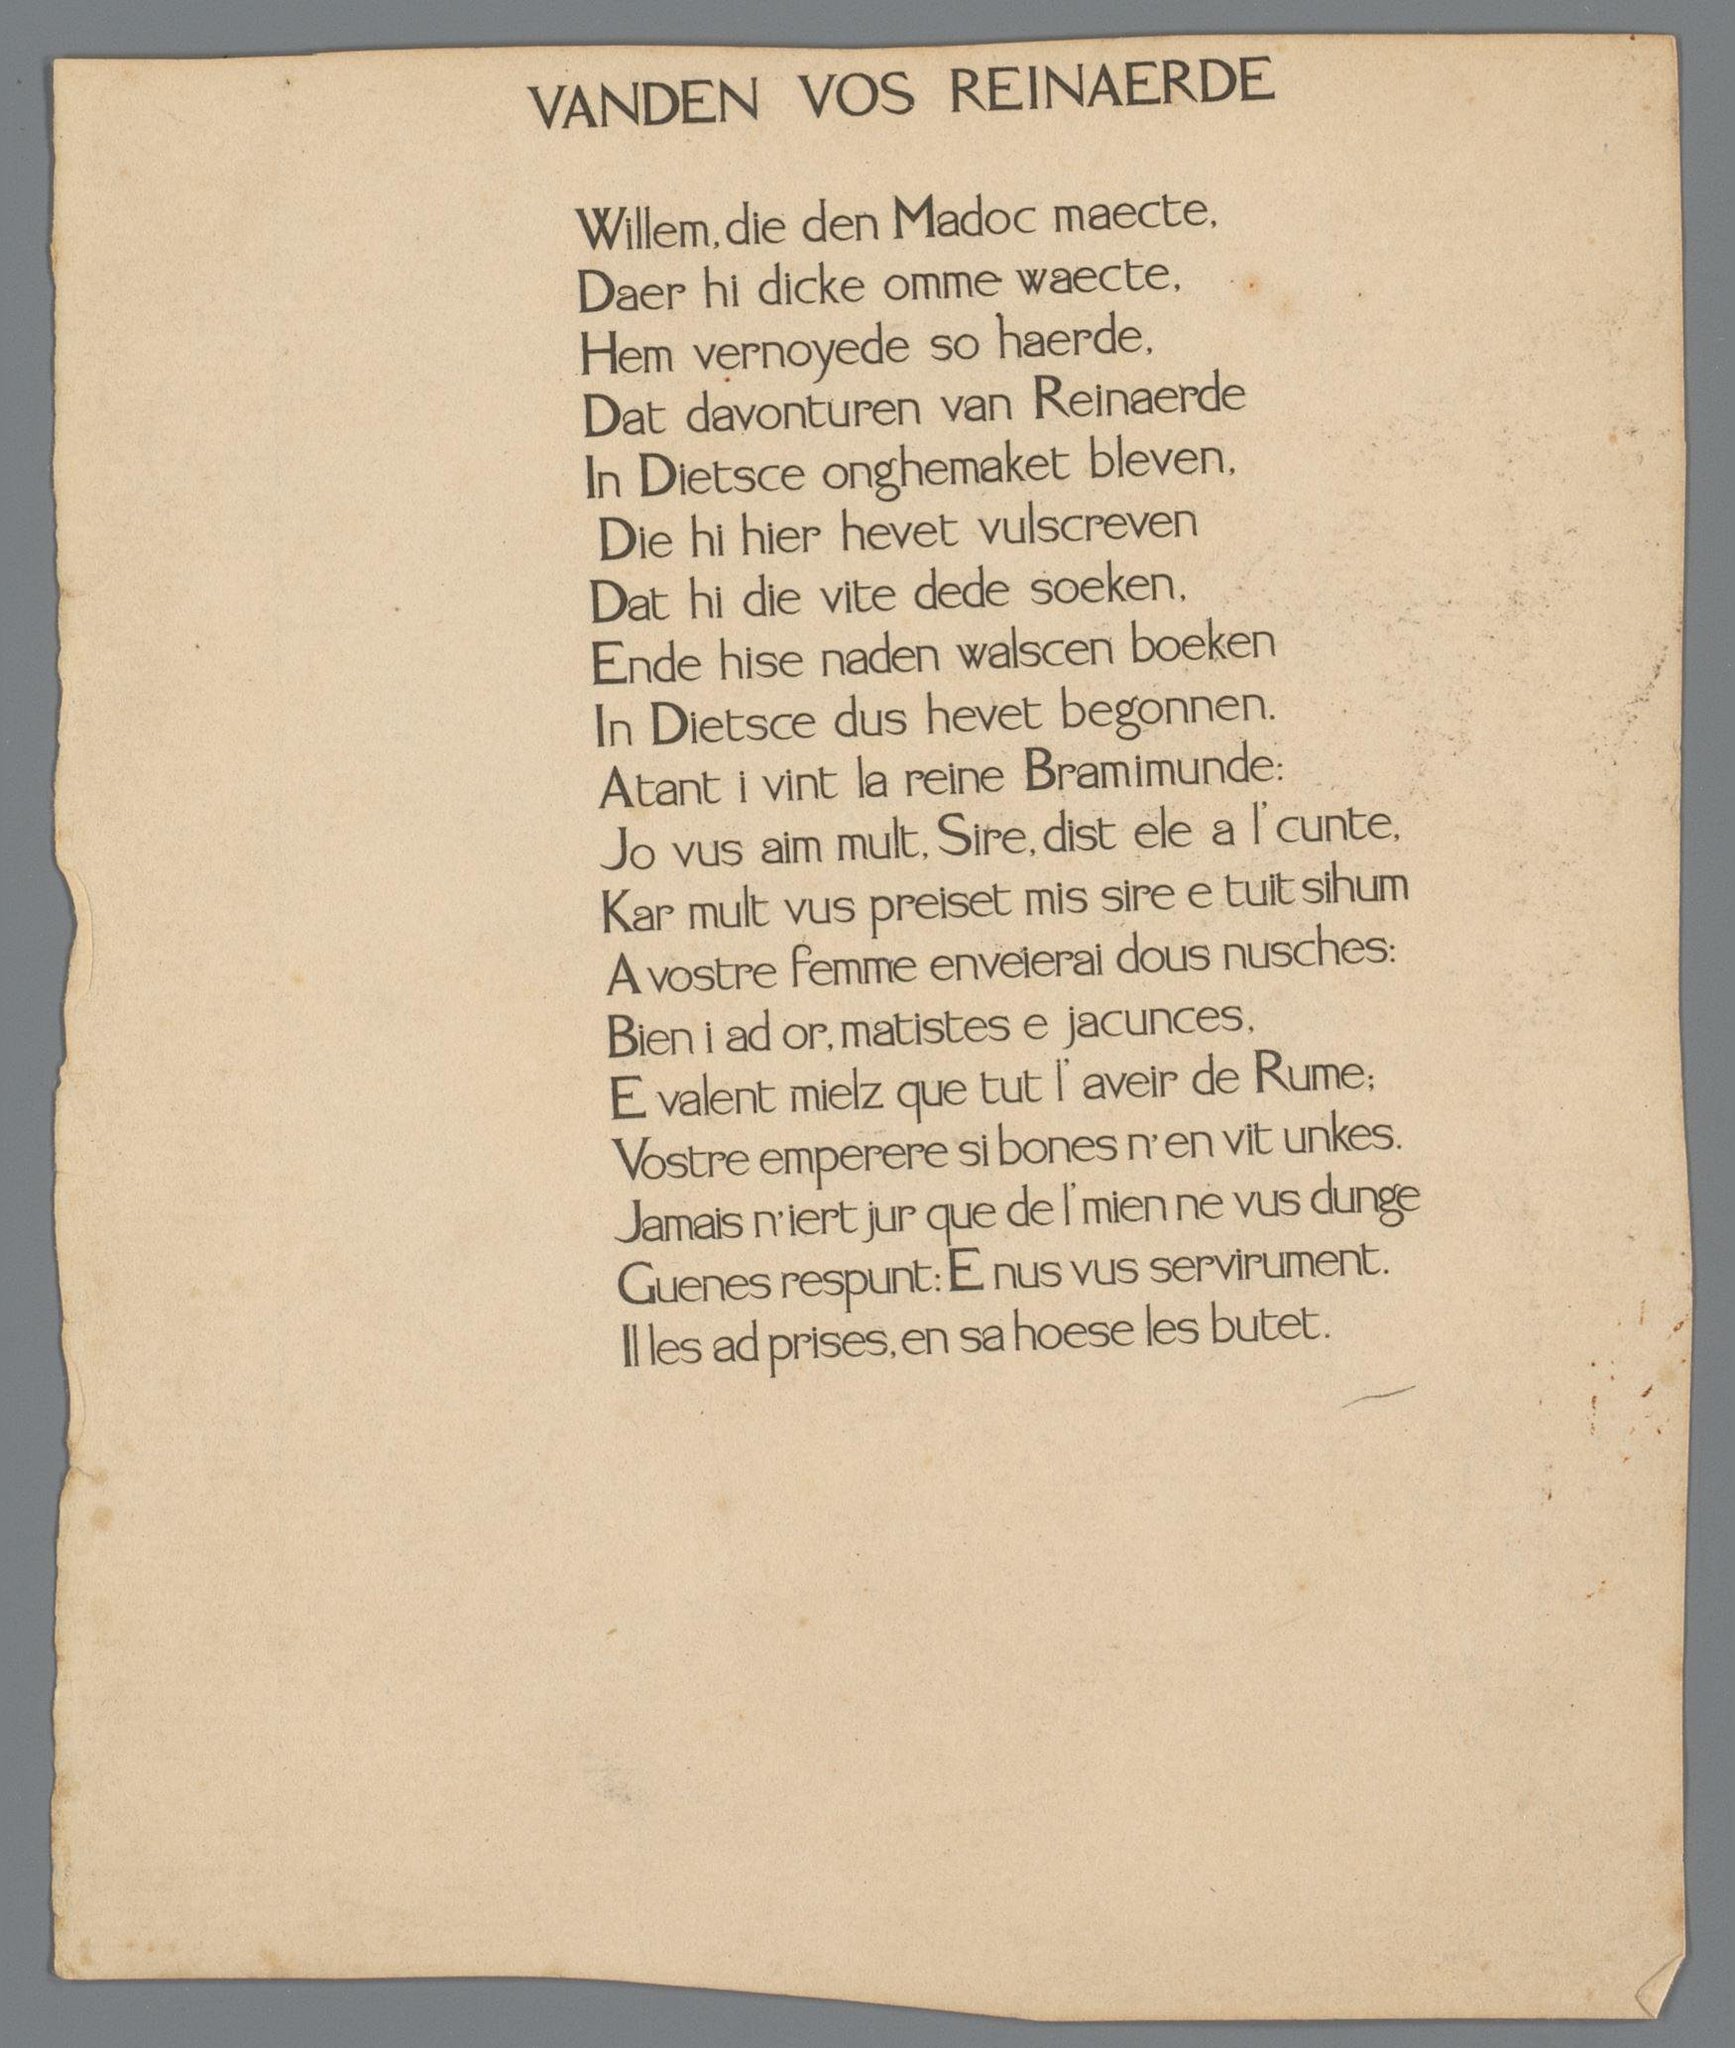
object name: text sheet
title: Vanden vos Reinaerde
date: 1896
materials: paper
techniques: photolithography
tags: printed matter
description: De hier weergegeven letter is fotolithografisch verkleind van het origineel dat door Gerrit Willem Dijsselhof in hout gesneden werd.